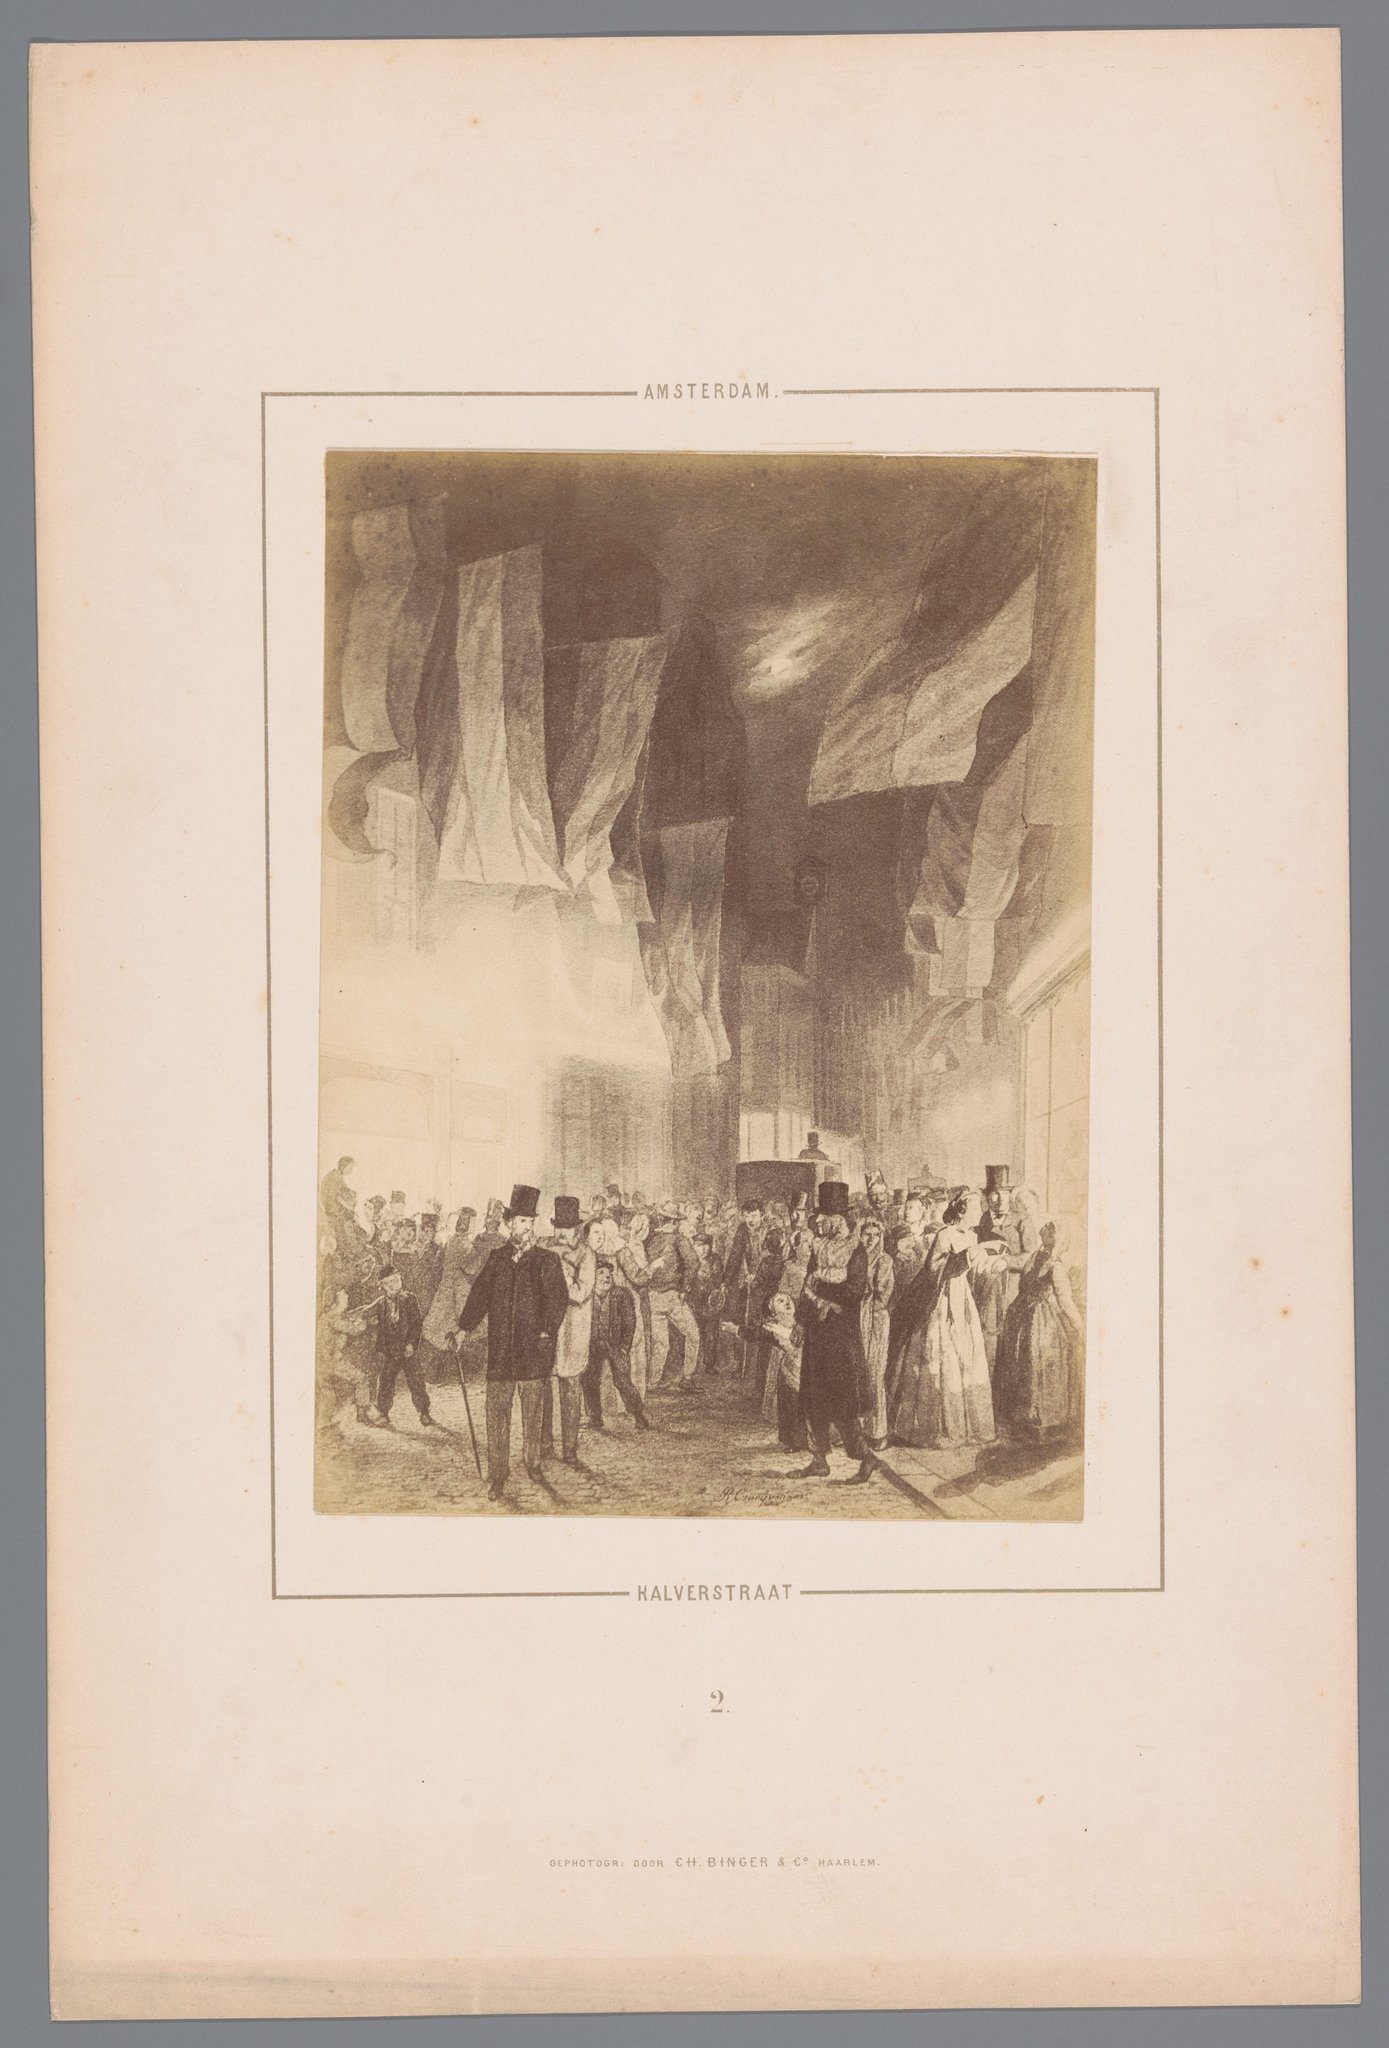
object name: reproduction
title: Fotoreproductie van een tekening van de Kalverstraat door Reinier Craeyvanger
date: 1867-1882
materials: cardboard, photographic support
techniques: gelatin silver print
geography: haarlem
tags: street (+ city(-scape) with figures, staffage)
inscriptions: inscription: ‘Amsterdam/ Kalverstraat/ 2/ Gephotgr: door Ch. Binger & Co. Haarlem’